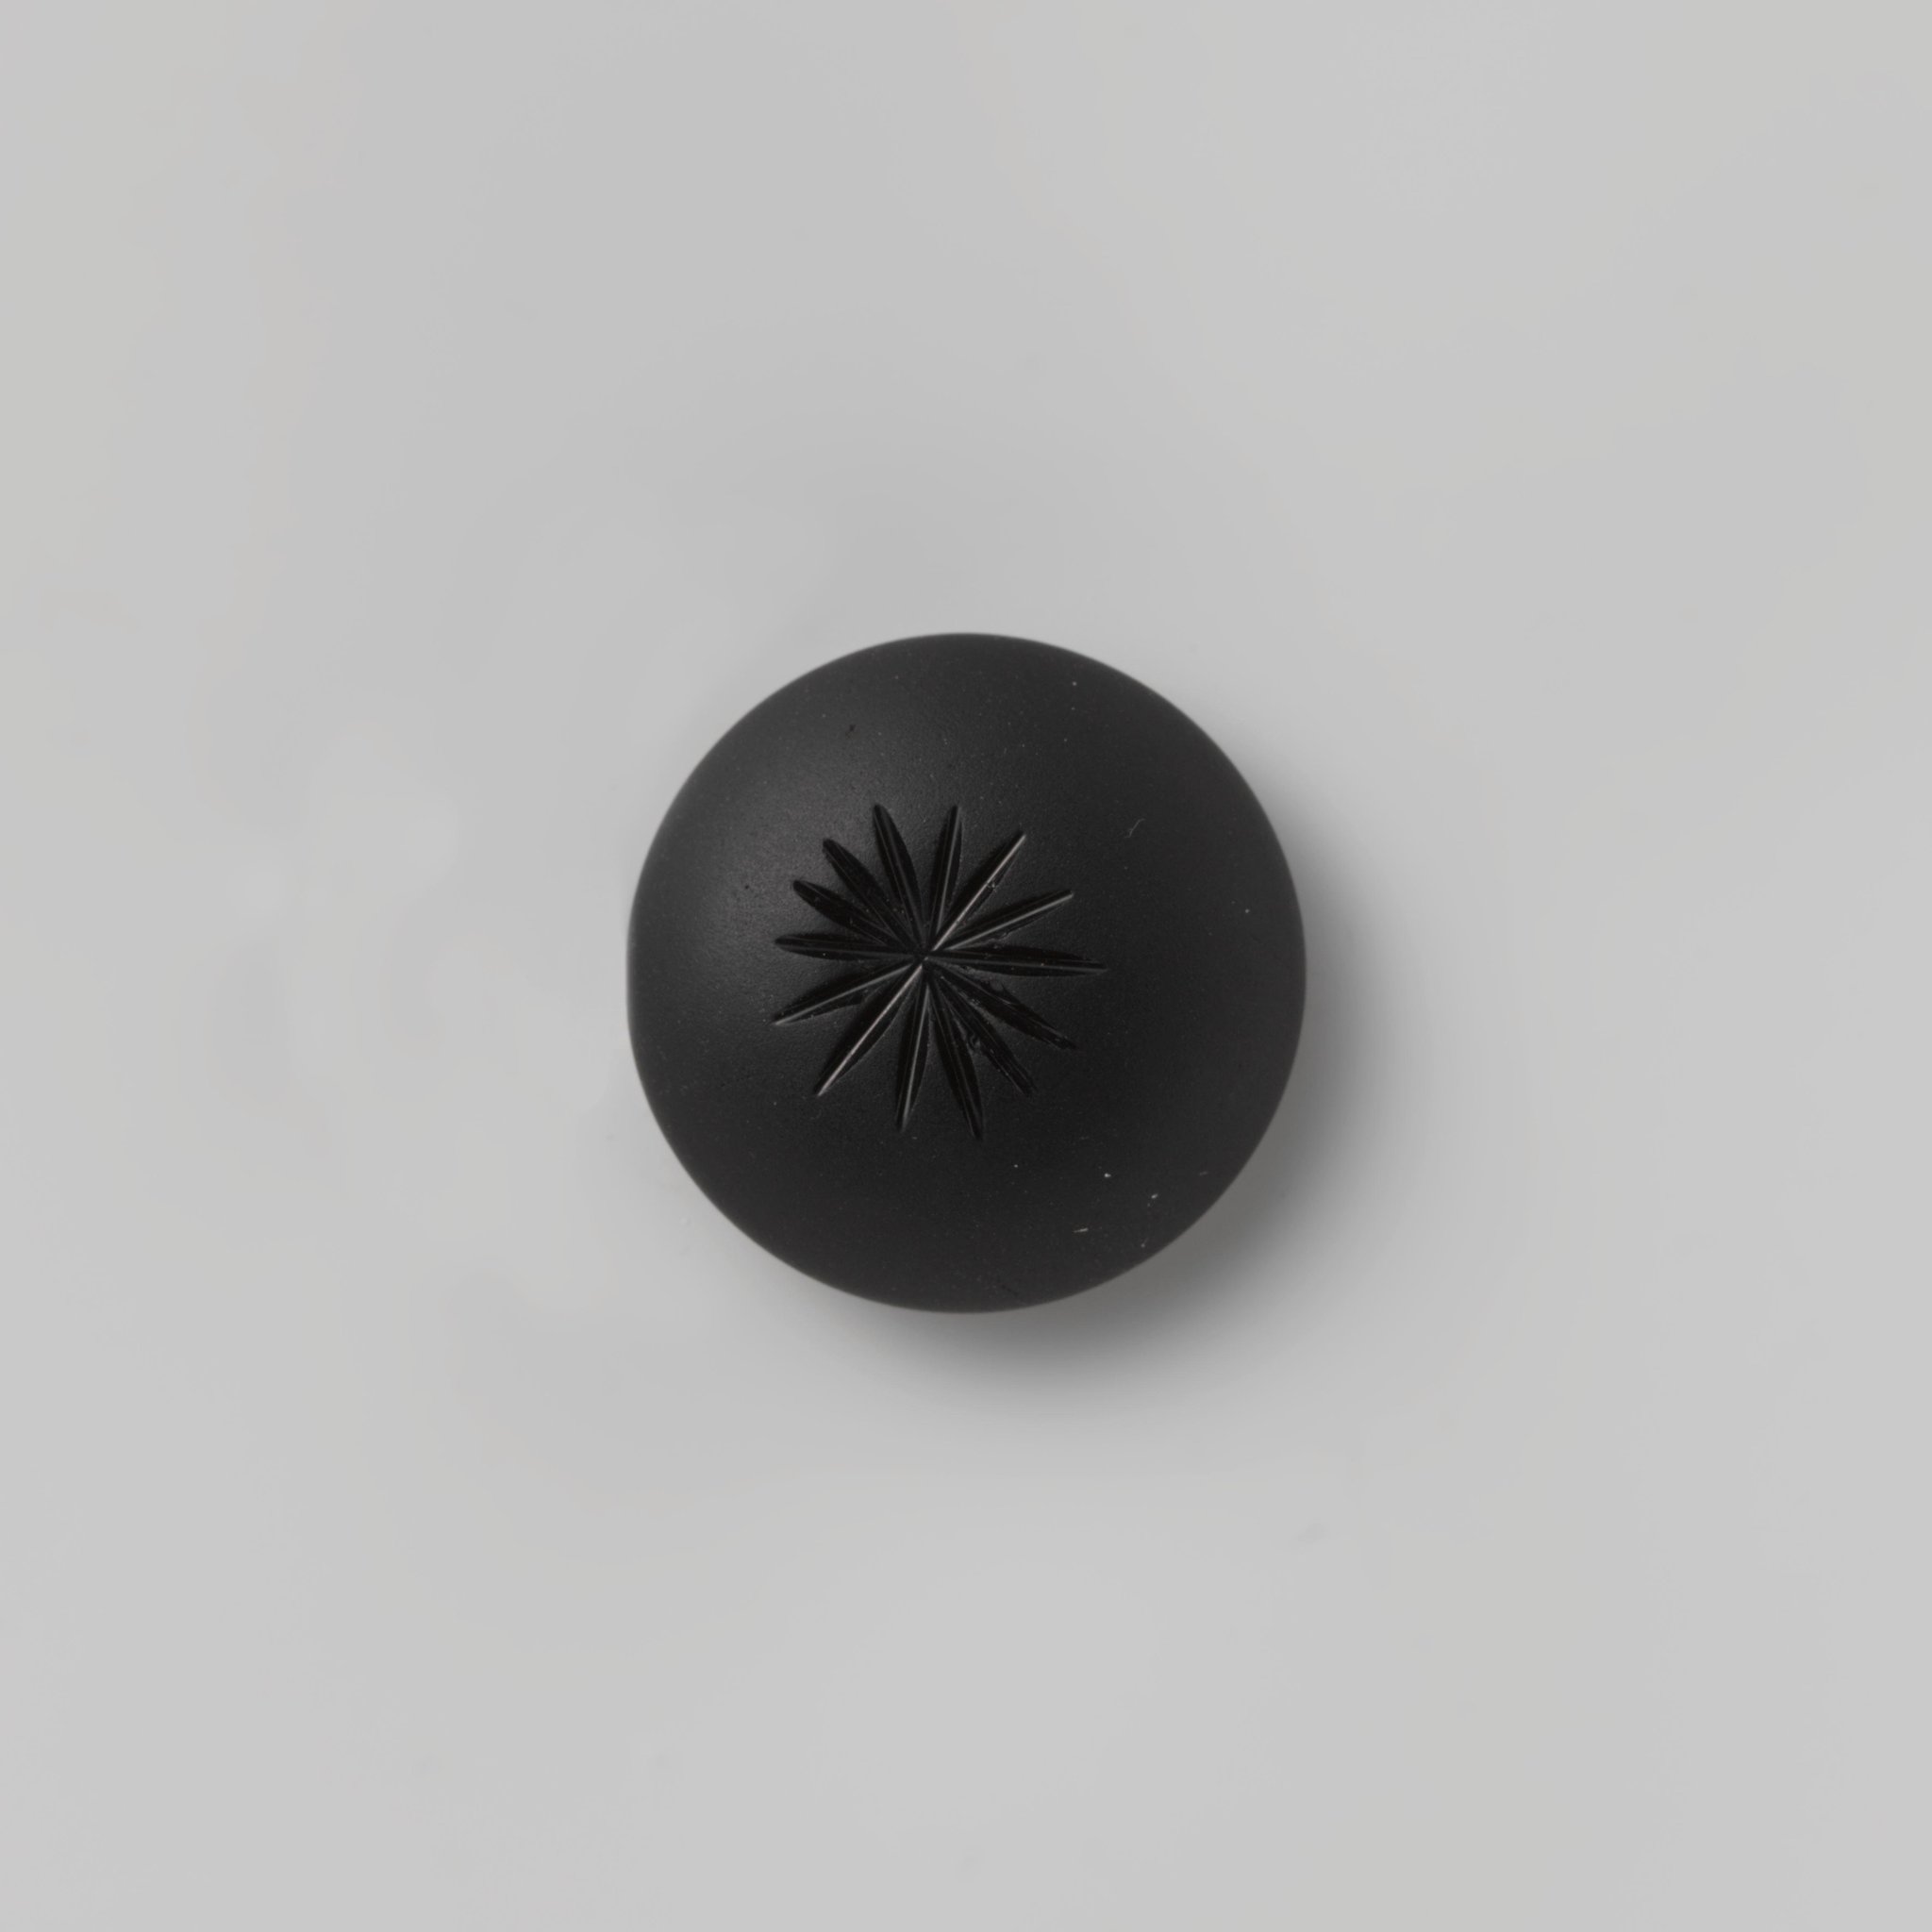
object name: brooch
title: Ronde rouwbroche van glas en zilver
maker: Anonymous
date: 1880-1900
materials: glass, silver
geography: europe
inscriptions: duty mark: ‘zwijnskop’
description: Ronde convexe rouwbroche van zwart glas met een ster in reliëf in het midden op een brochering met haaksluiting van zilver.